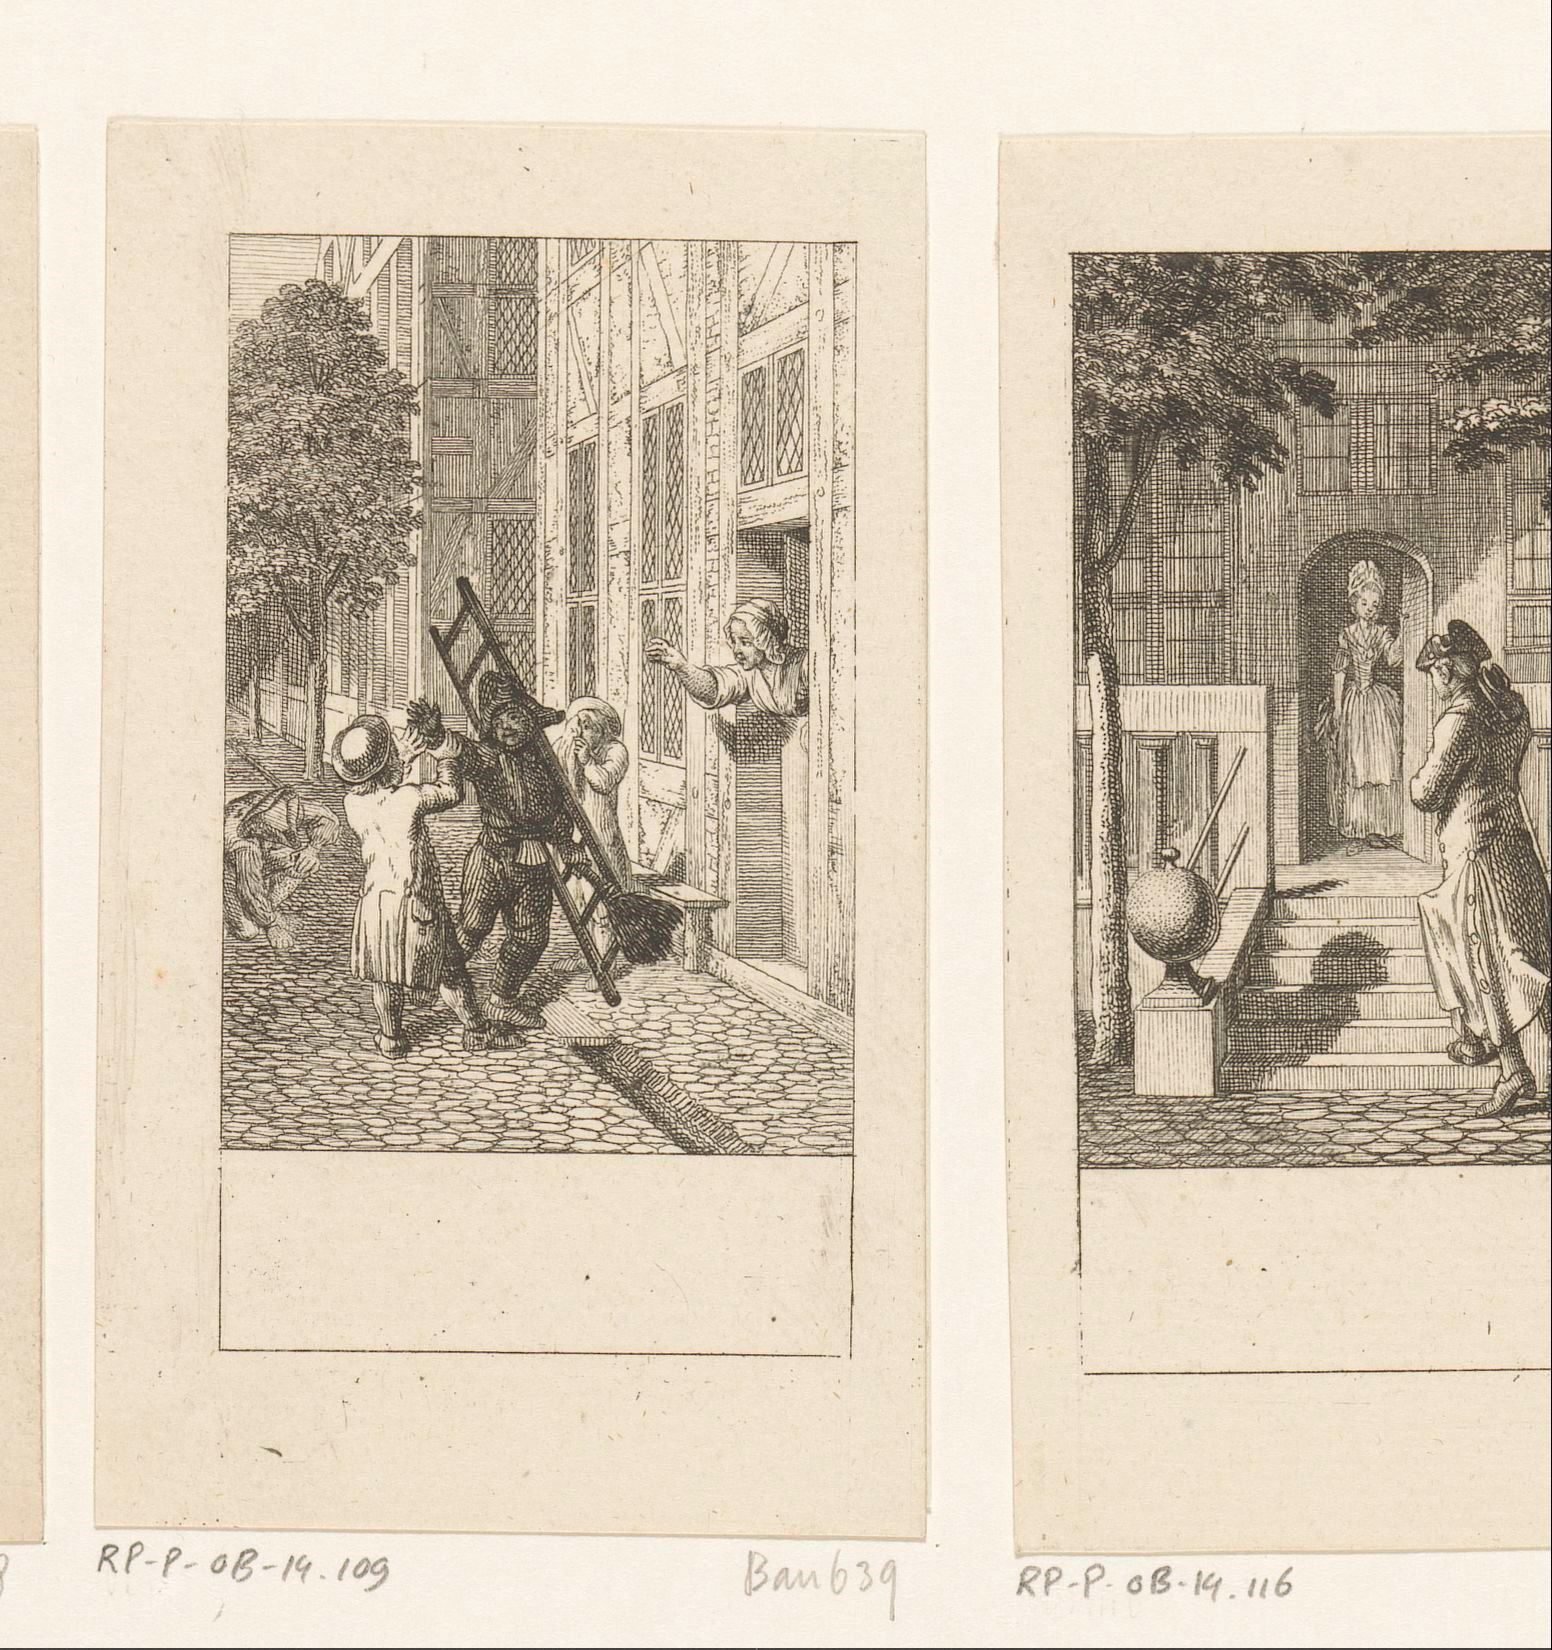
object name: print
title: Ruffin de schoorsteenveger maakt voorbijgangers zwart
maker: daniel nikolaus chodowiecki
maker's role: draughtsman, print maker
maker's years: 1726-1801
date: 1779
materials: paper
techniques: etching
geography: berlin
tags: handicrafts ~ maintenance and repair (with name of trade or profession), street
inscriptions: collector's mark: Lugt 2228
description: Derde prent afkomstig uit een serie van twaalf verschillende prenten. De scènes zijn op een plaat geëtst. Een latere staat van deze serie is ook gebruikt in: Lauenburger genealogischen Kalender auf das Jahr 1780.